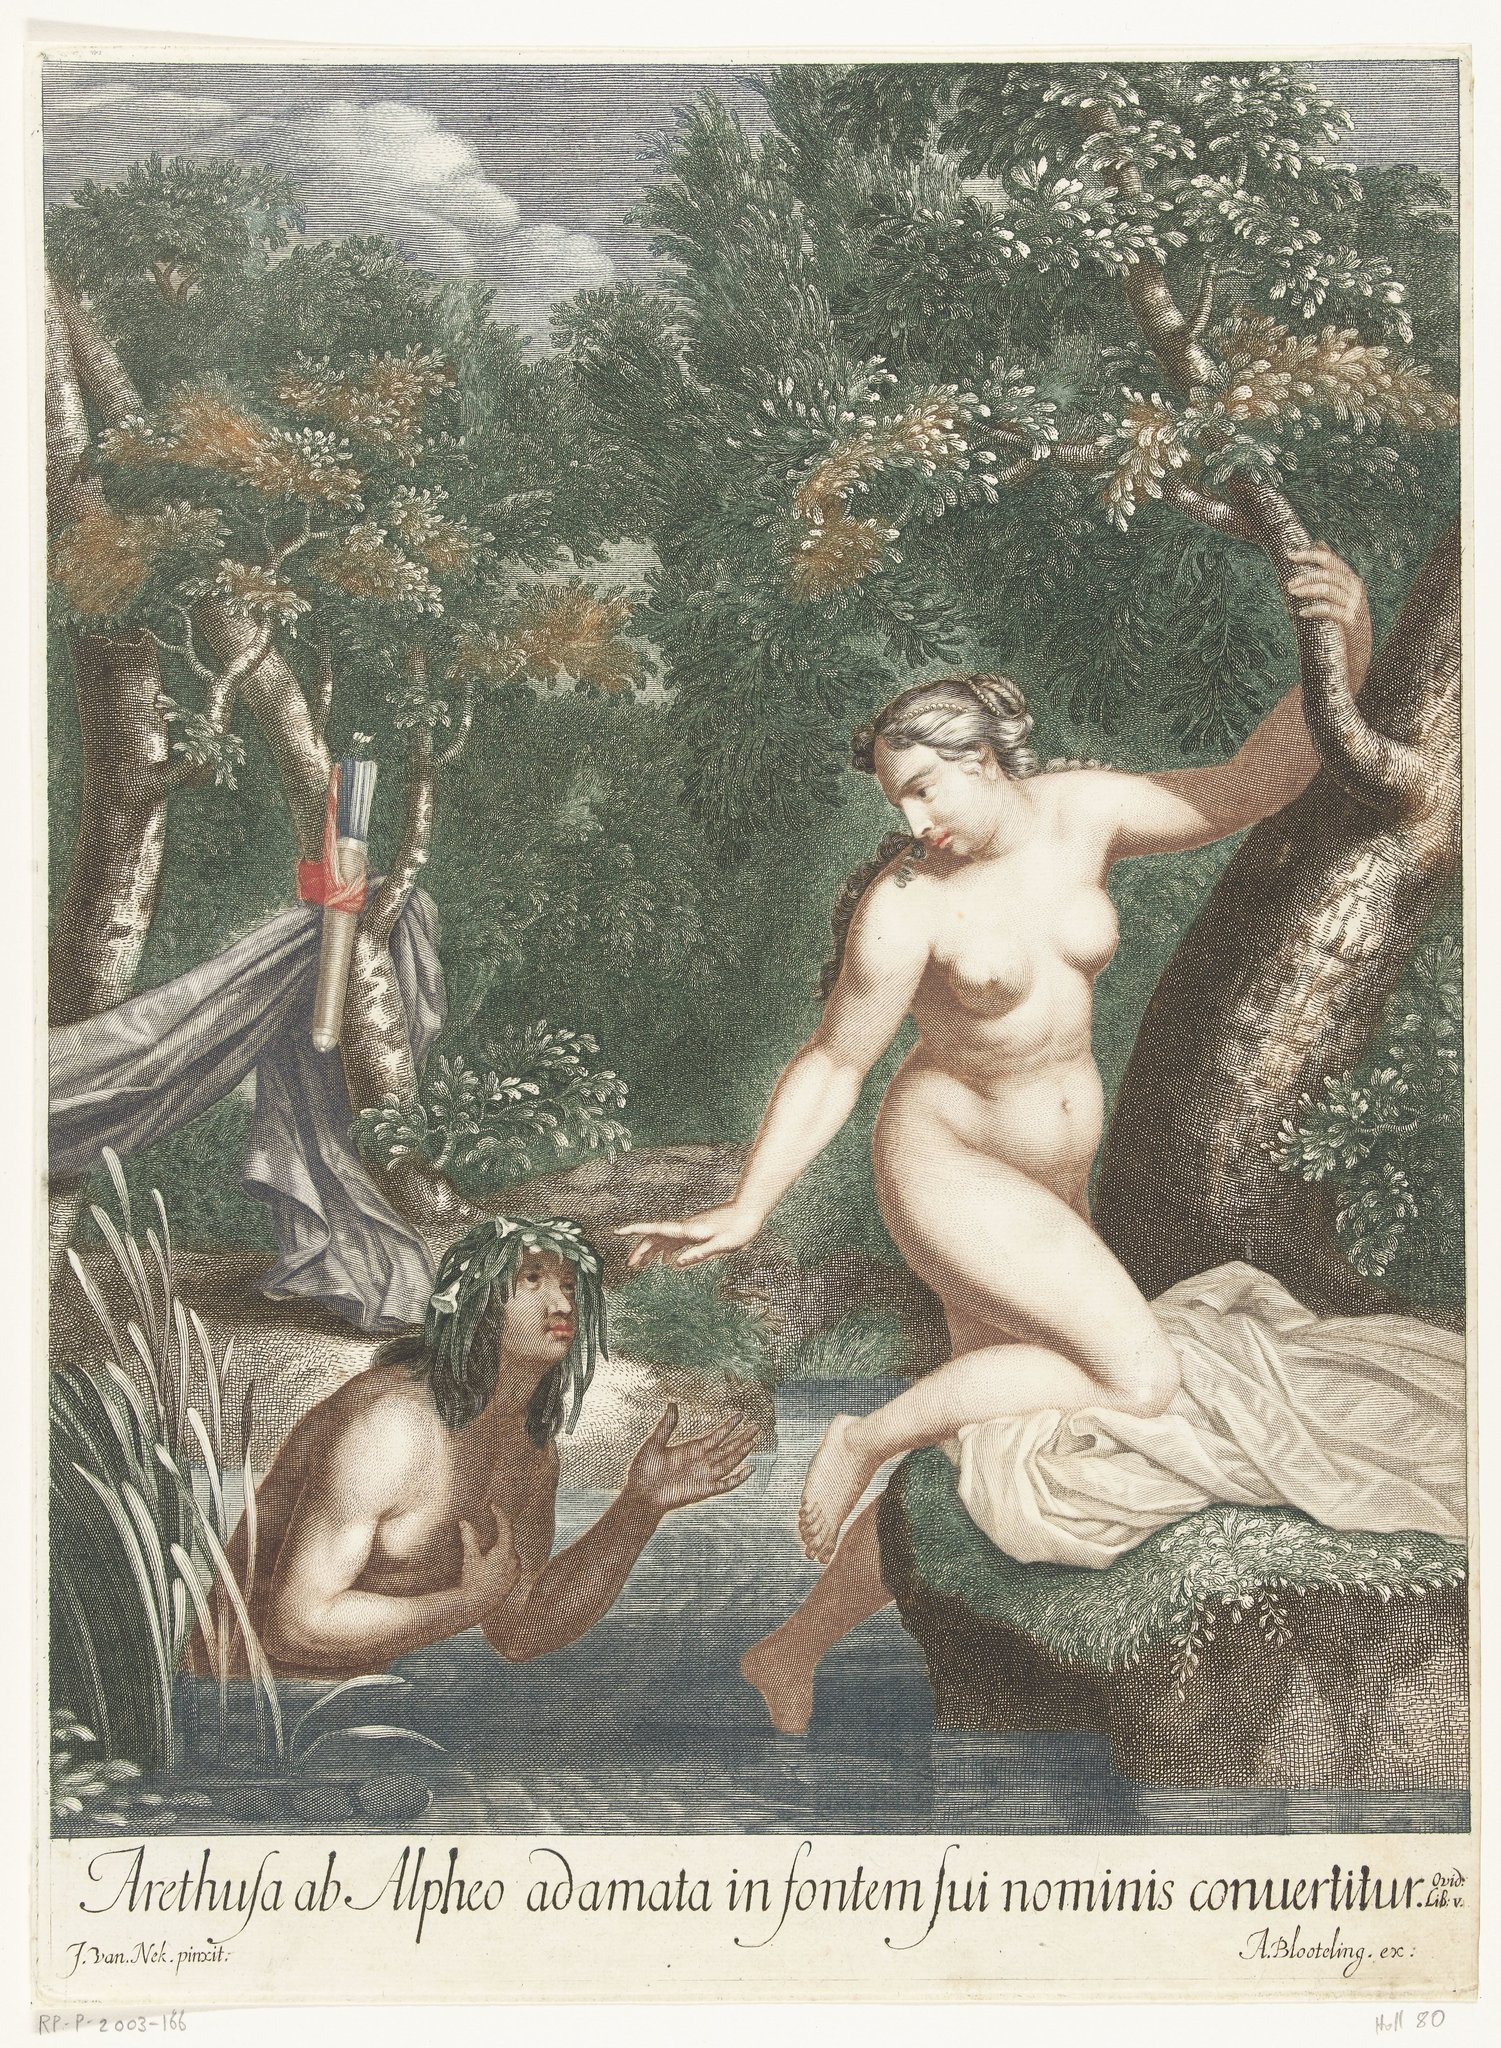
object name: print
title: Alpheüs en Arethusa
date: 1655-1690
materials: paper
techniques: engraving, etching, lithography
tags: alpheus changed into a river-god: when pining away for the love of arethusa, alpheus the hunter is changed into a river-god (pausanias v 7, 2), other nereids (or sea-nymphs): arethusa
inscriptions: title: ‘Arethusa ab Alpheo...convertitur Ovid. Lib: V’, collector's mark: Lugt 2228, collector's mark: Lugt 2760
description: De nimf Arethusa vlucht voor de riviergod Alphëus uit het water. Aan een tak van een boom die aan de oever staat trekt ze zich omhoog. Op de achtergrond hangt aan een boom een pijlenkoker als symbool van de liefde. Onder de prent een vers uit de Metamorfosen van Ovidius.